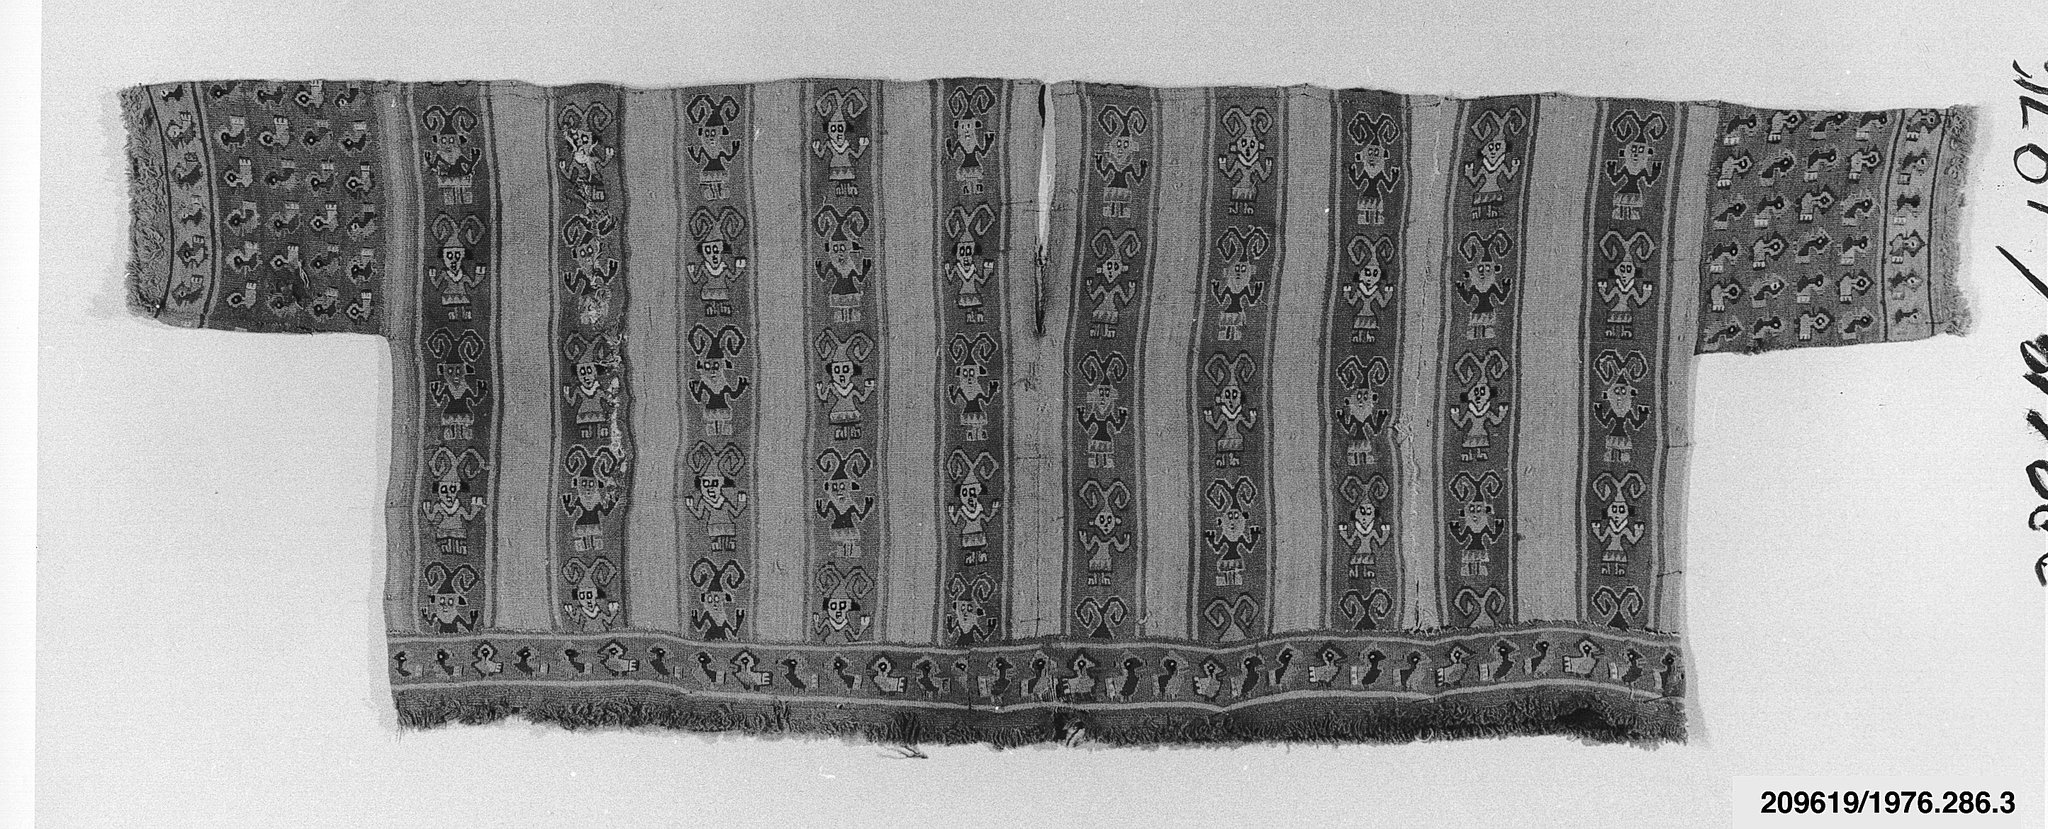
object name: tunic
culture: central coast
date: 1101-1500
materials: animal fiber, cotton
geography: peru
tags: human figures